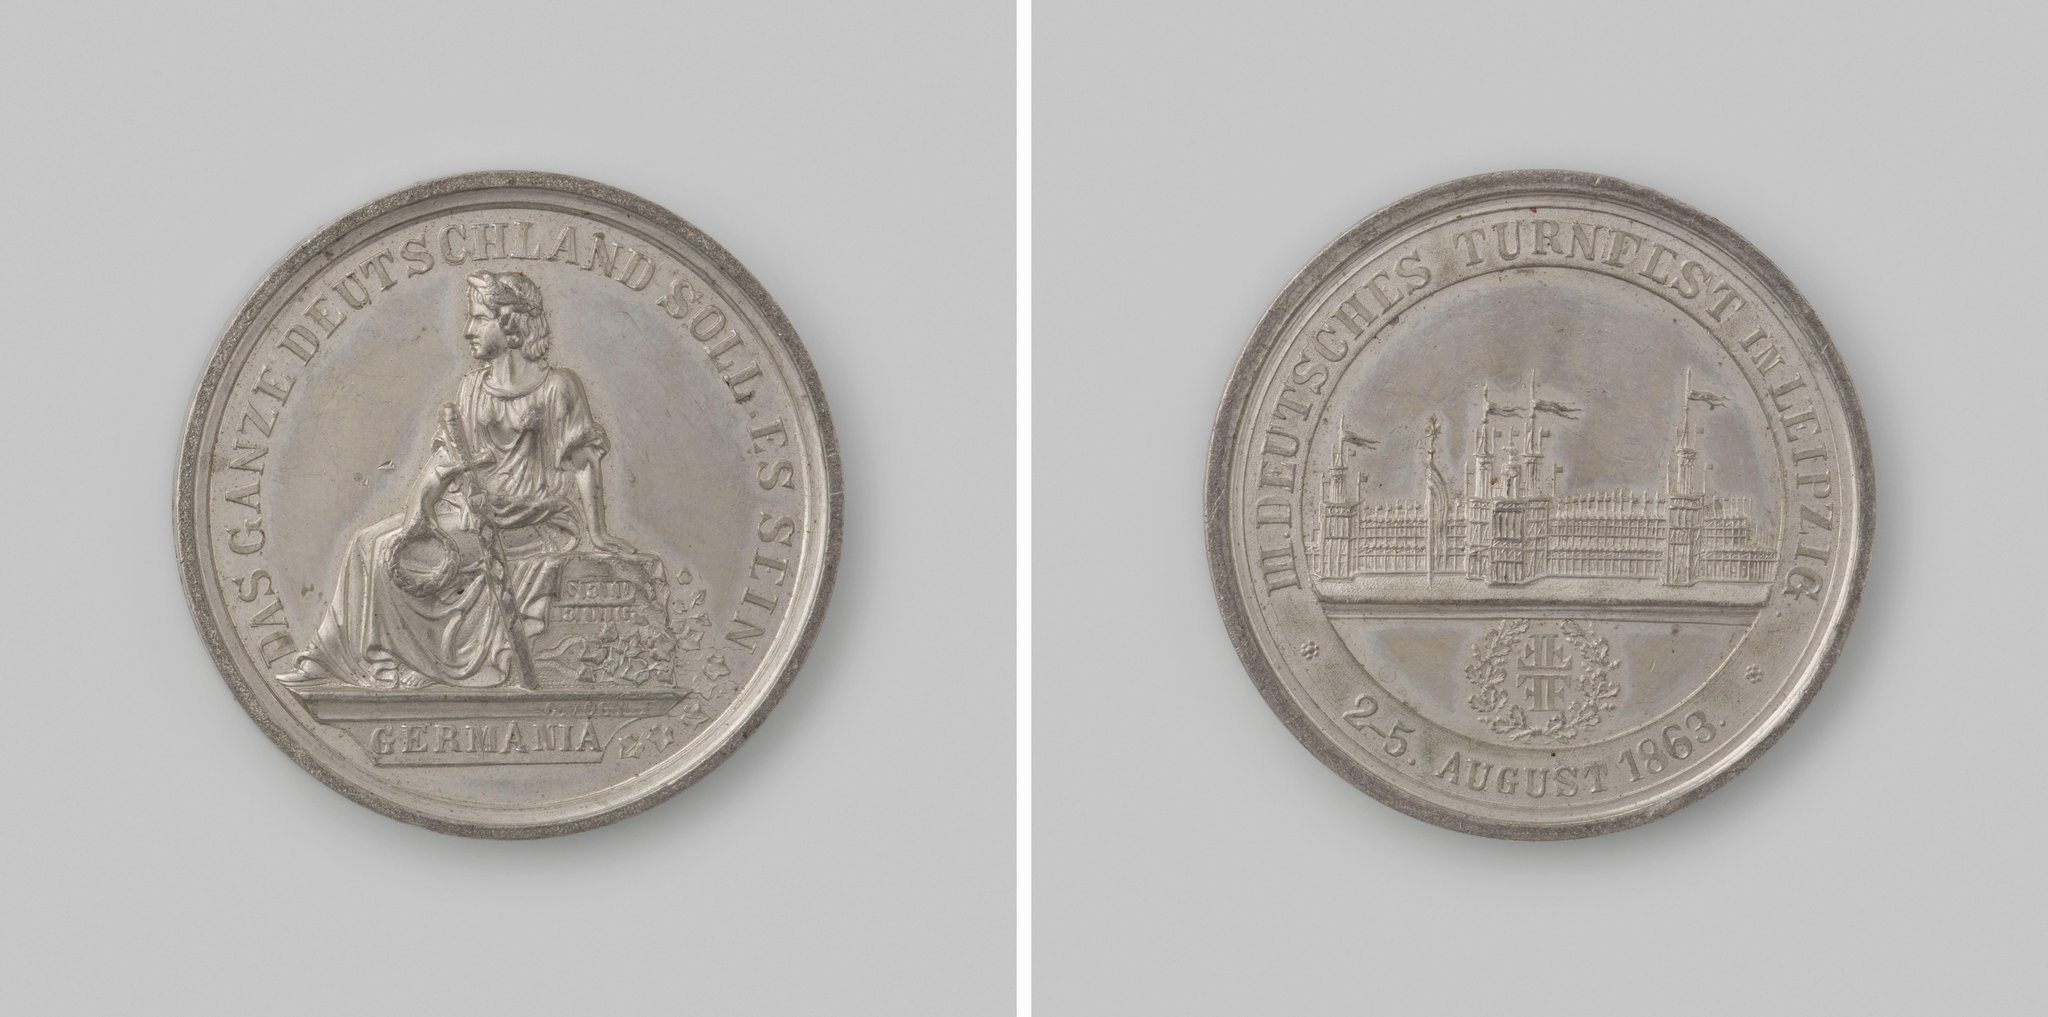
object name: history medal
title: Derde Duitse turnfeest te Leipzig 1863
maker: carl friedrich voigt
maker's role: medailleur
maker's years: 1800-1874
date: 1863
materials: tin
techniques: striking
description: Tinnen pennig, op de voorzijde Germania zittend naar links met lauwerkrans, met omschrift en afsnedetekst, op de keerzijde het feestgebouw boven een monogram in een krans, met omschrift.